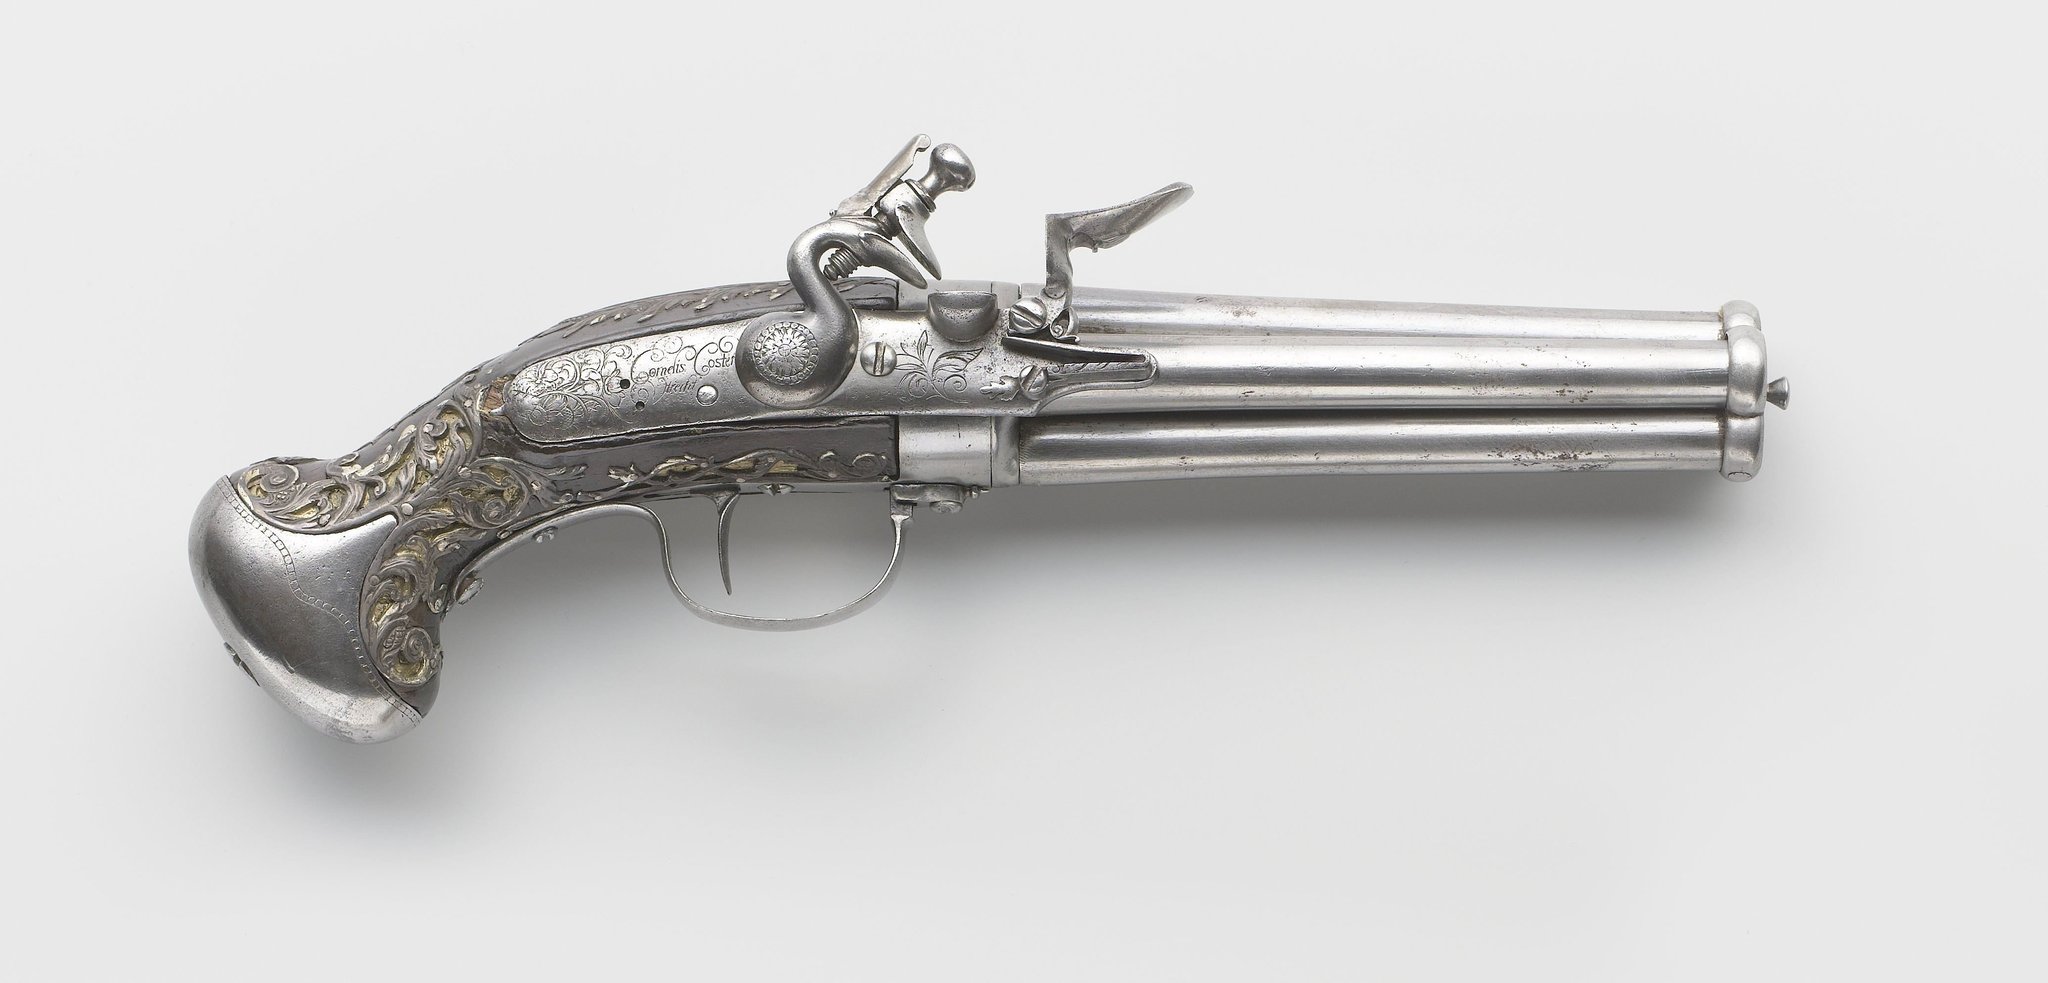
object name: draailooppistool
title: Vierloops vuursteendraailoopzakpistooltje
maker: cornelis coster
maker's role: geweermaker, pistoolmaker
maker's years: -1698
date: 1660-1670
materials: brass, iron, silver, steel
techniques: metalworking, embroidery, engraving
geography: utrecht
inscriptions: inscription: ‘Cornelis Coster // Vtrecht’